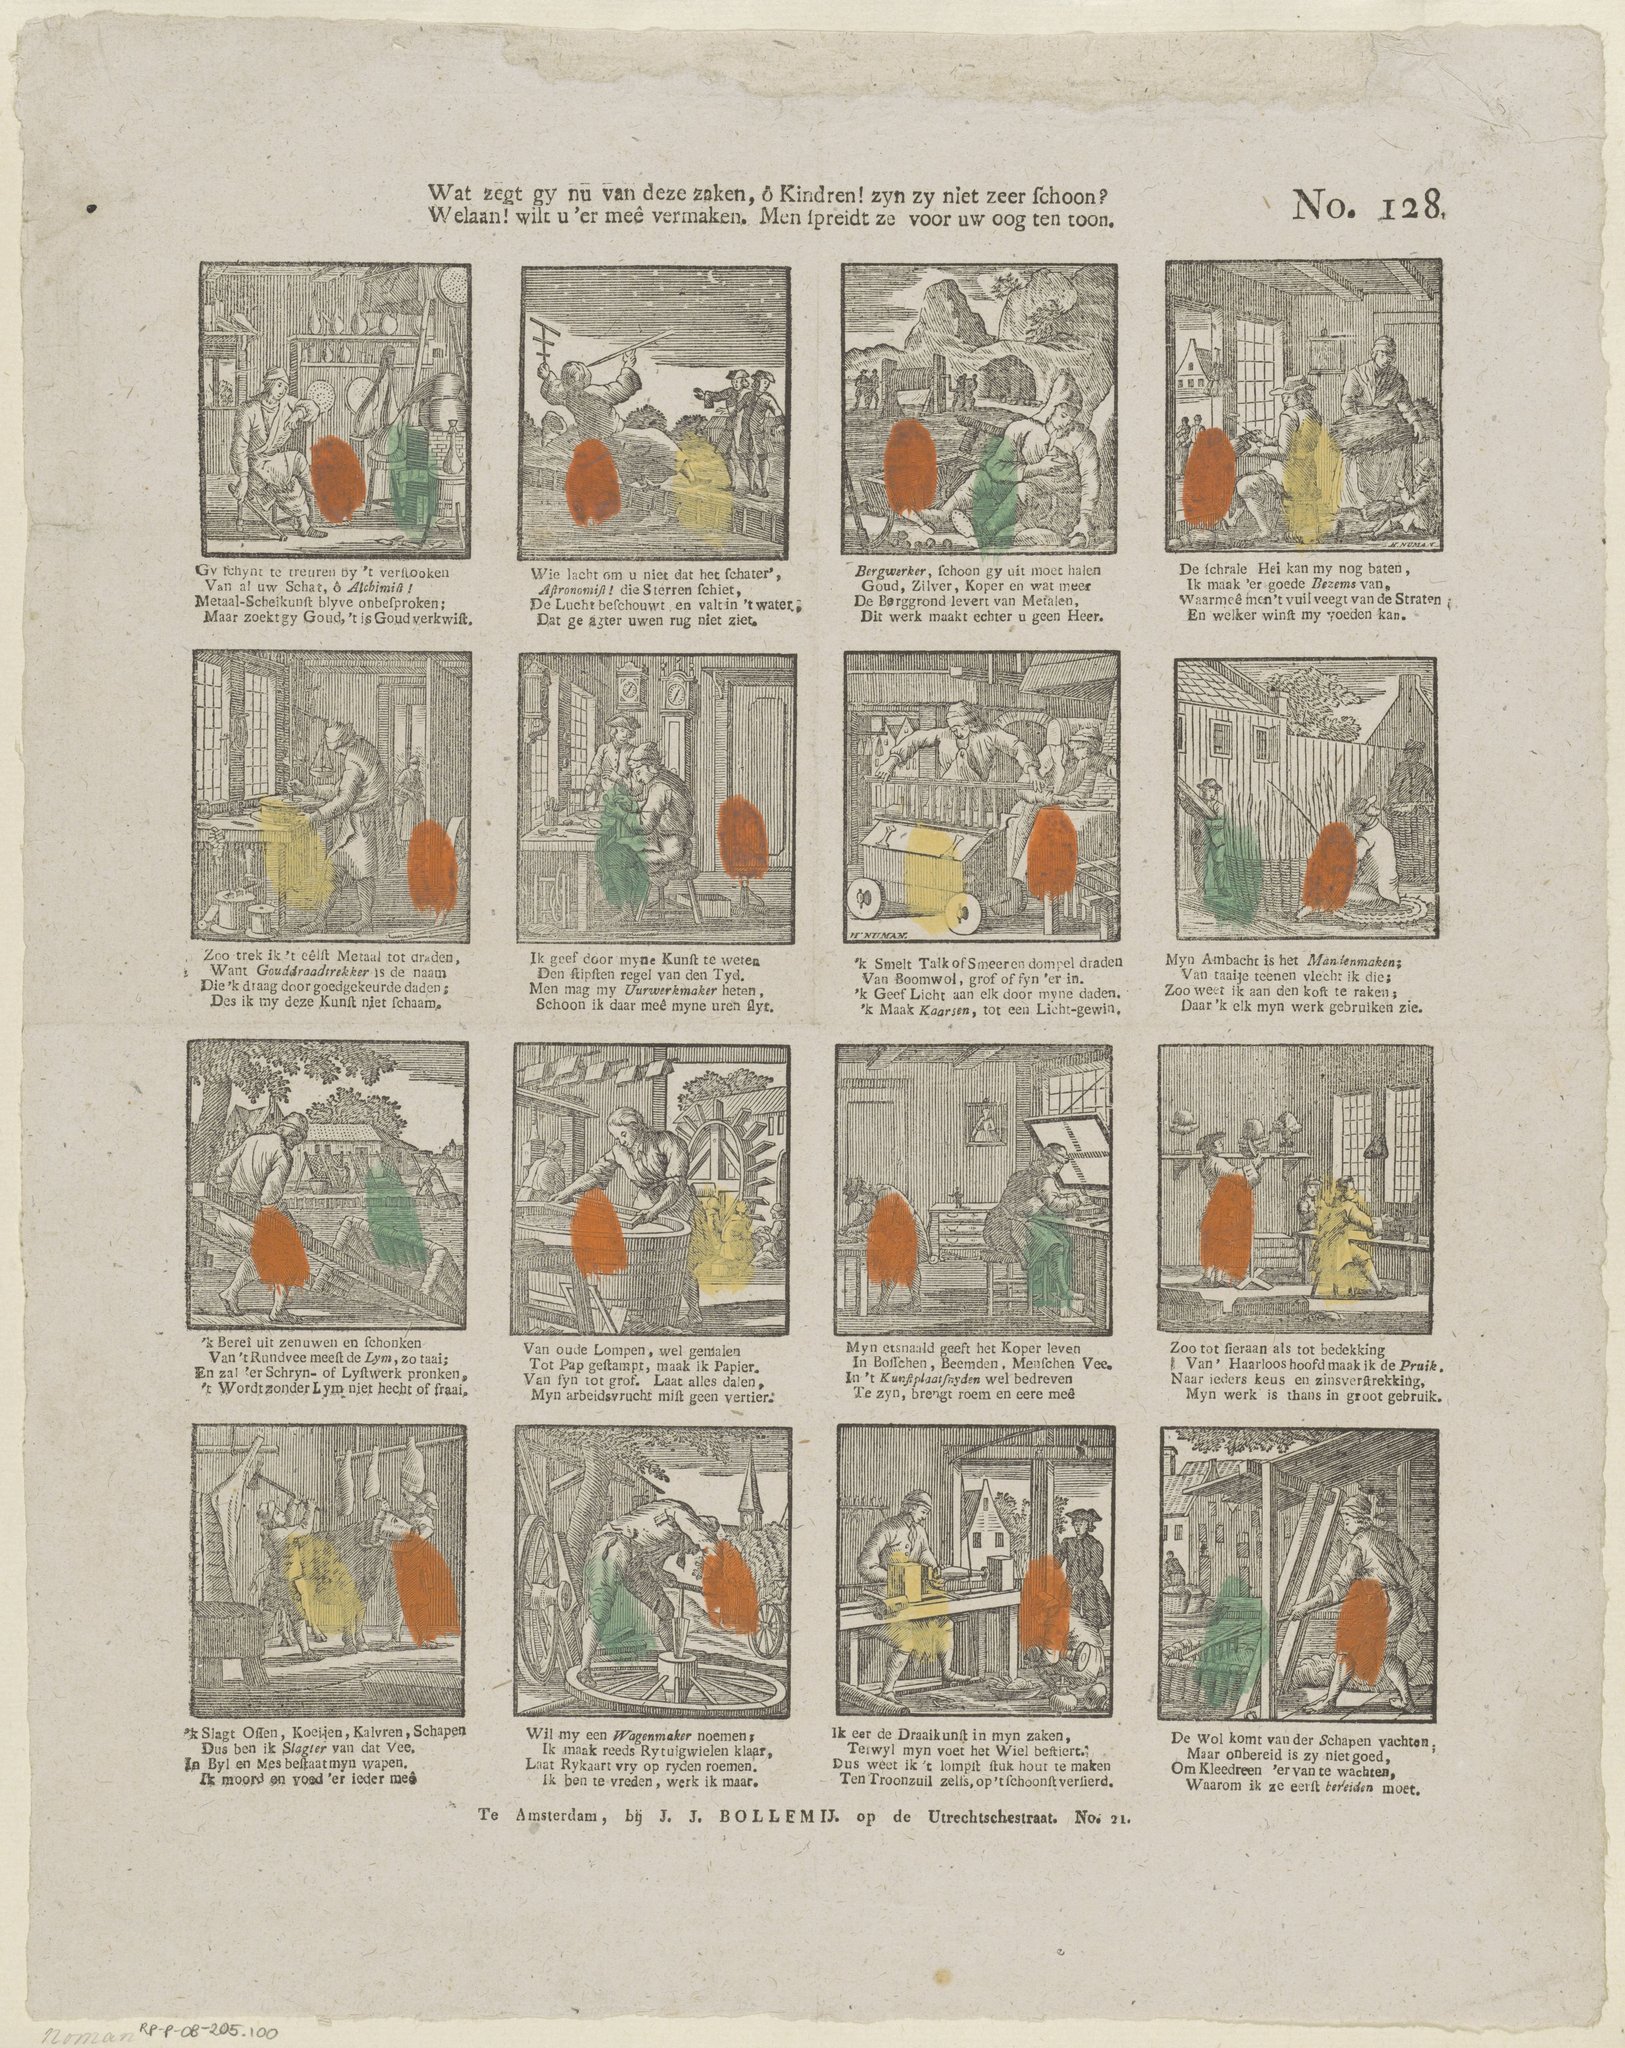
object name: popular print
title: Wat zegt gy nu van deze zaken, ô kinderen! zyn zy niet zeer schoon? / Welaan! wilt u 'er meê vermaken. / Men spreidt ze voor uw oog ten toon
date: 1806-1830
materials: paper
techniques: colour, letterpress printing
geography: zaltbommel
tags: carpenter, craft-production, skilled handiwork, butcher, slaughterman, crafts and industries, watchmaker, clockmaker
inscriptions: collector's mark: Lugt 2760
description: Blad met 16 voorstellingen van ambachtslieden en beroepen, zoals bezemmaker, horlogemaker en papiermaker. Onder elke afbeelding een vierregelig vers. Genummerd rechtsboven: No. 128.